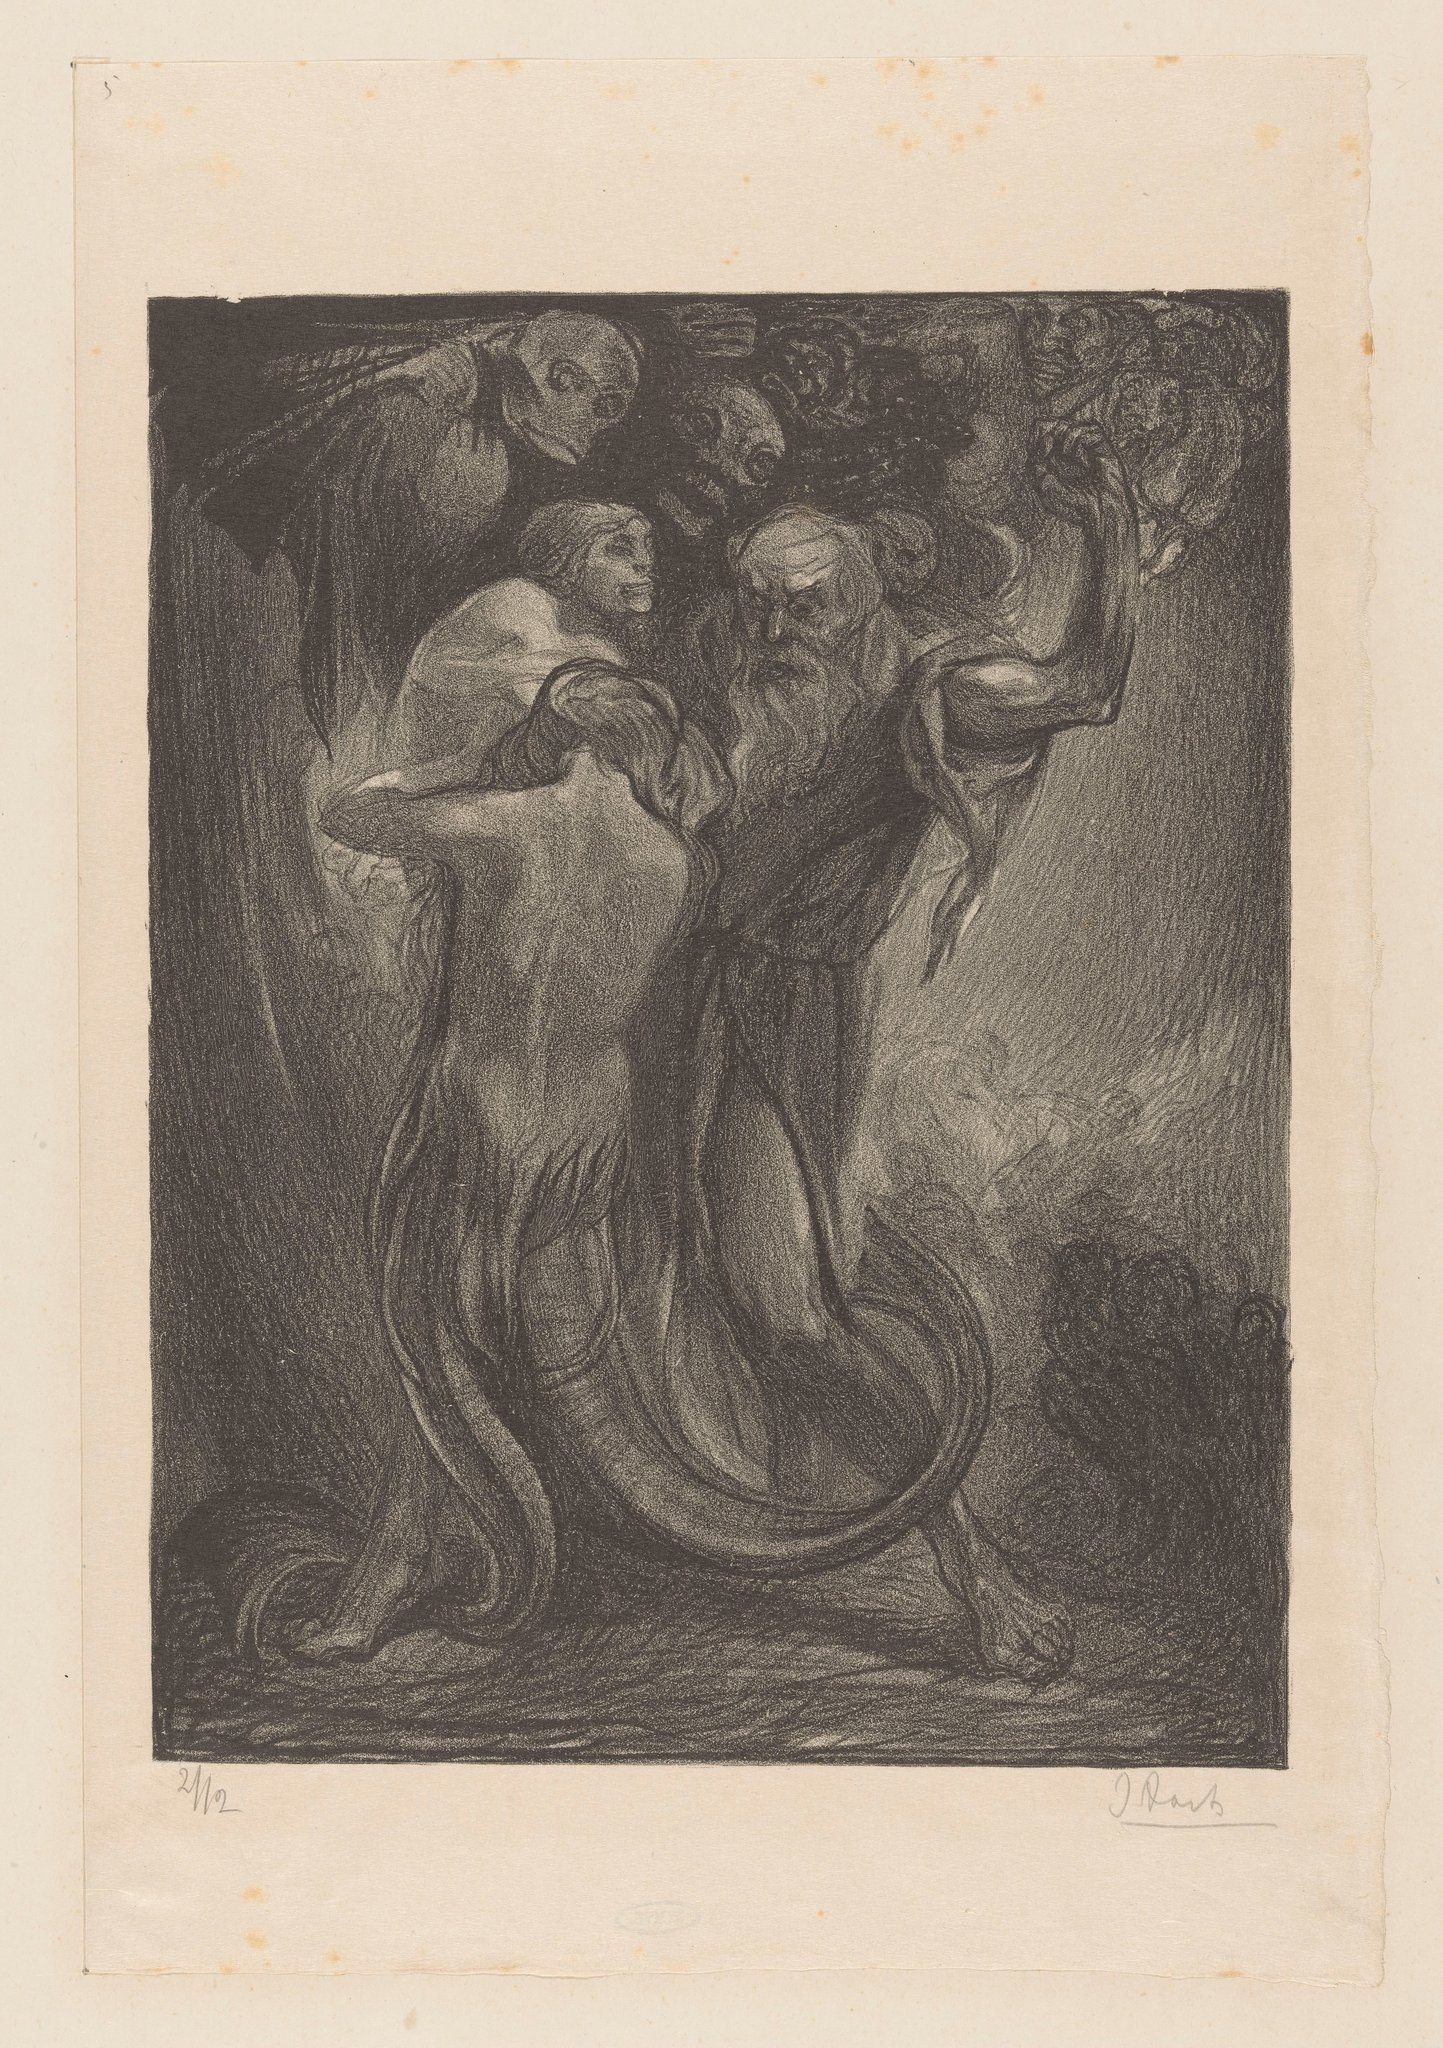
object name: print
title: De verzoeking van de Heilige Antonius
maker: johannes josephus aarts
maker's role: draughtsman, print maker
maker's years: 1871-1934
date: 1927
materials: paper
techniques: lithograph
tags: devil or demons attacking mortals, mis-shapen animals; monsters, st. antony abbot tormented by devils, attacking him on the ground or carrying him aloft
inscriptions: collector's mark: Lugt 2228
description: Een bebaarde man in gevecht met een groep demonen, waarvan het merendeel in de lucht zweeft.